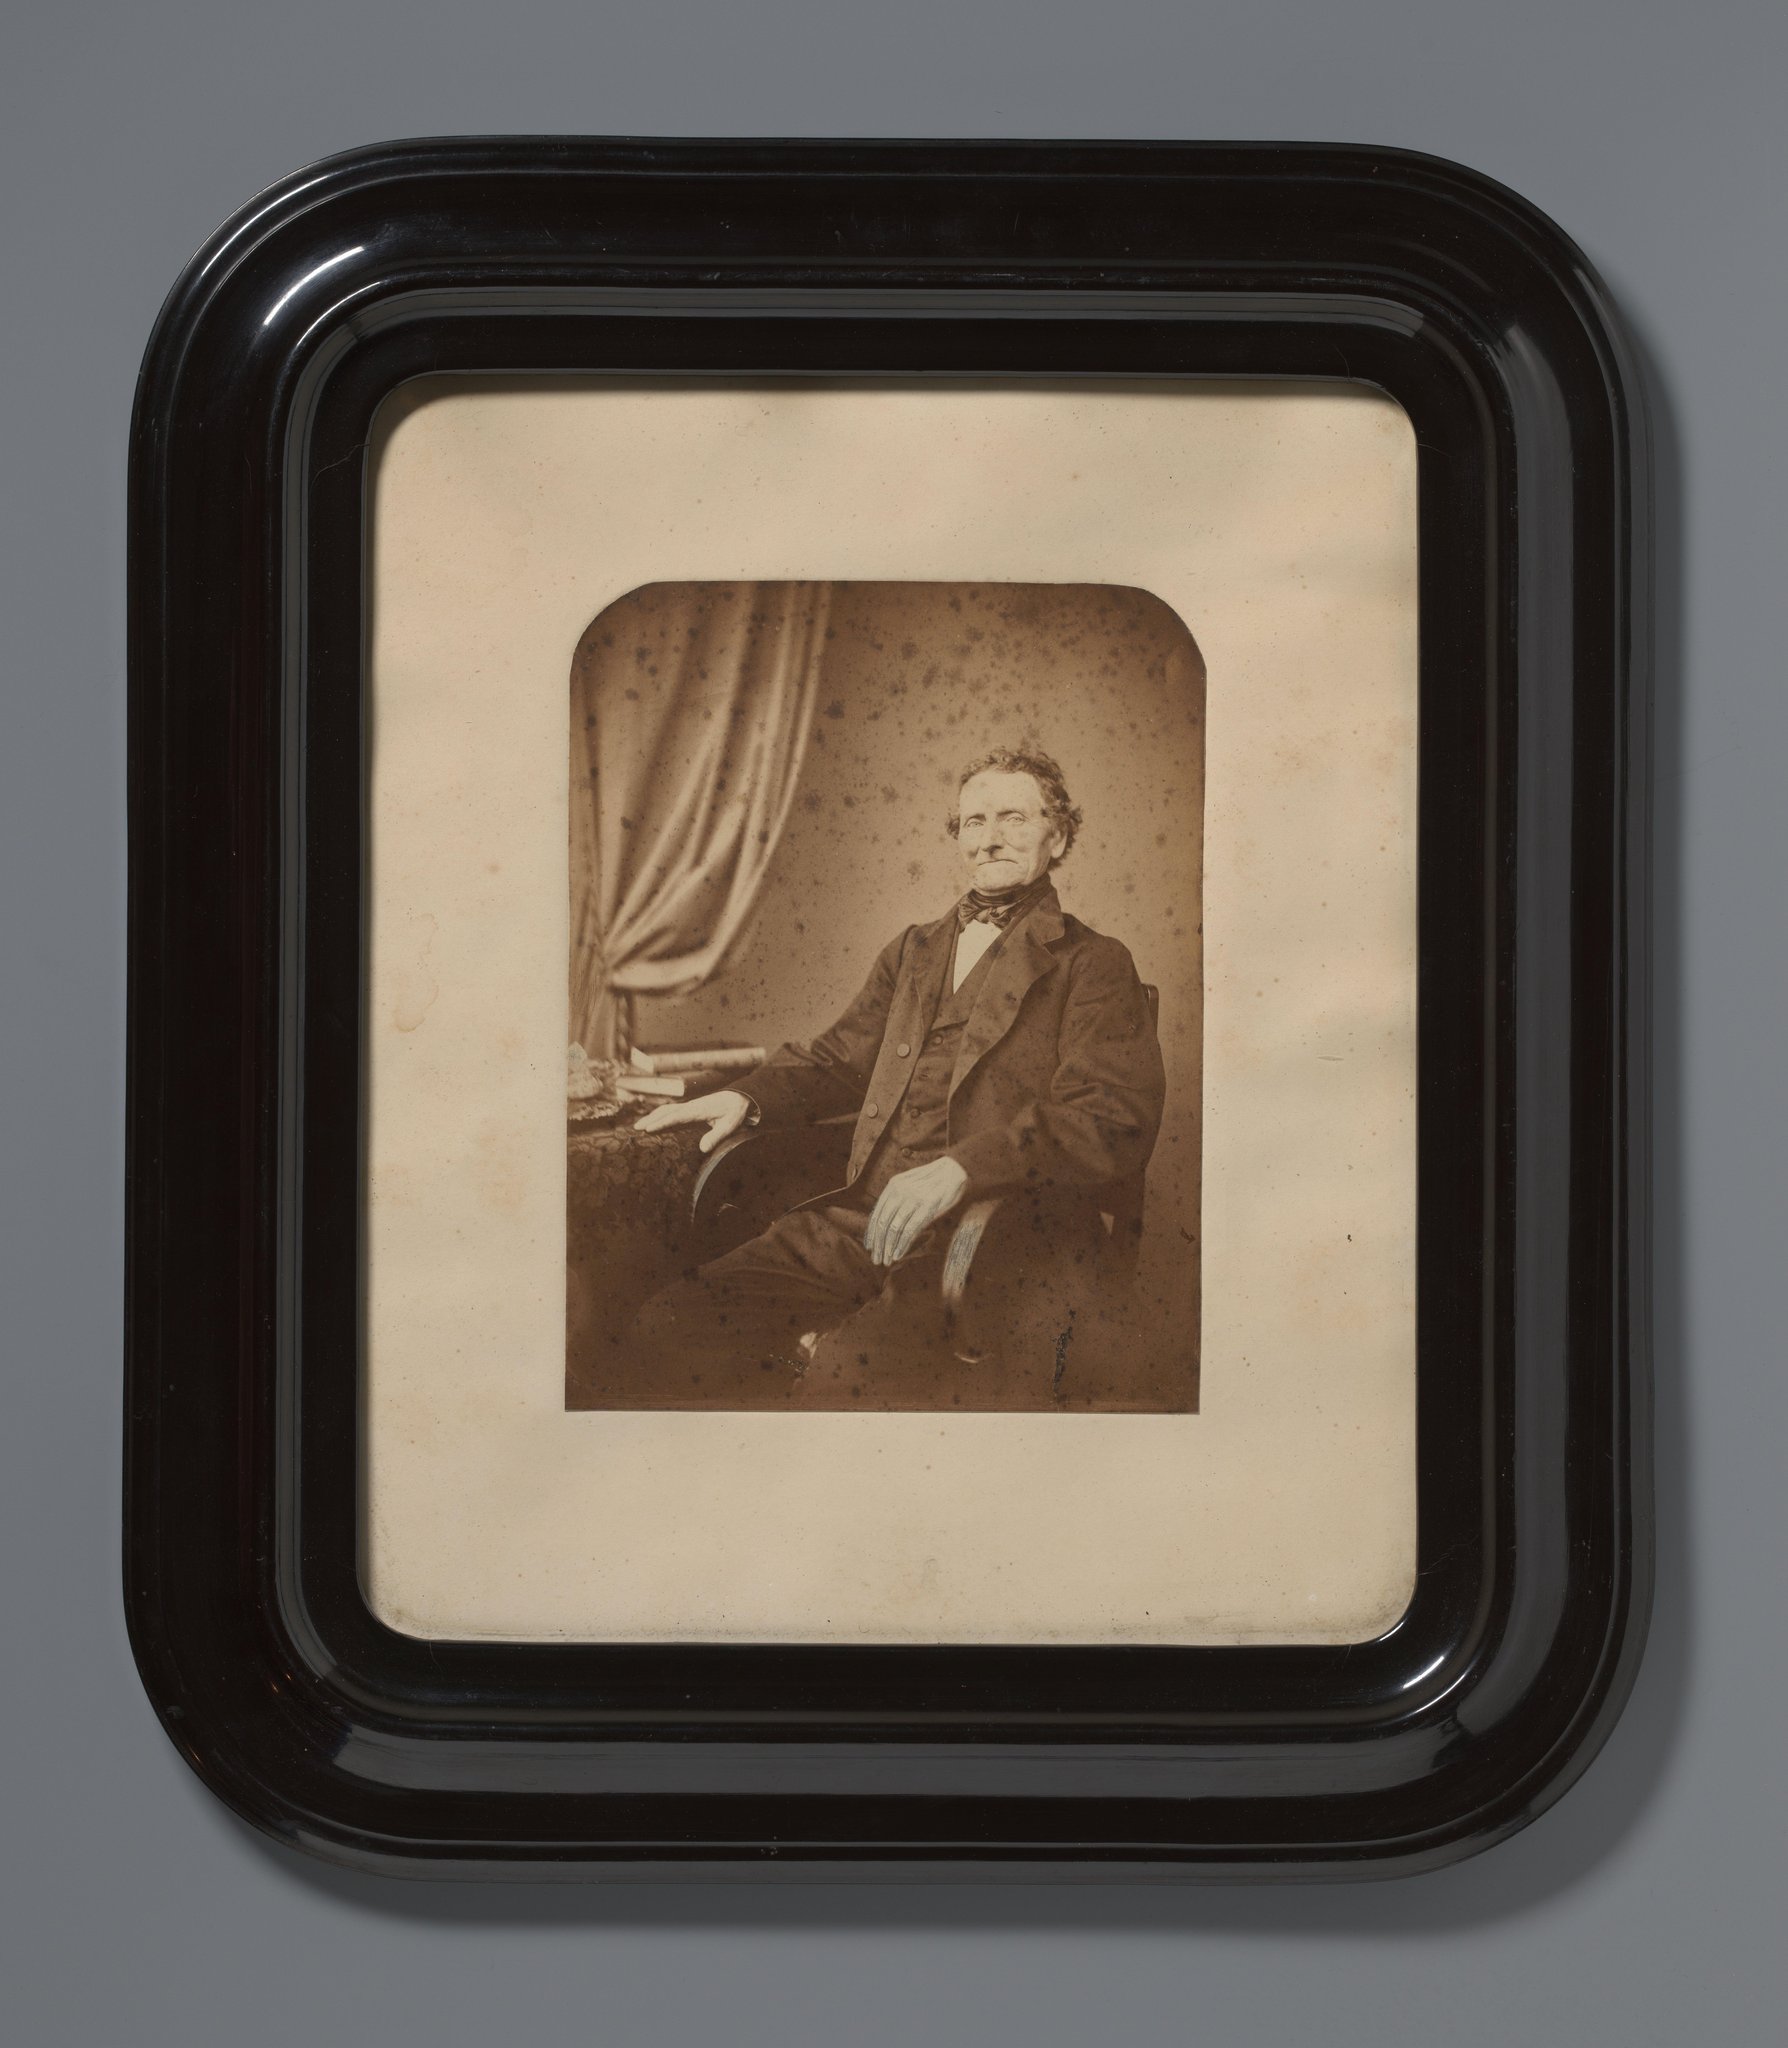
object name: frame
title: Portret van een onbekende man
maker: Anonymous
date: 1855-1880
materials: cardboard, glass, paper, wood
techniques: albumen print, retouching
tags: historical persons not known by name